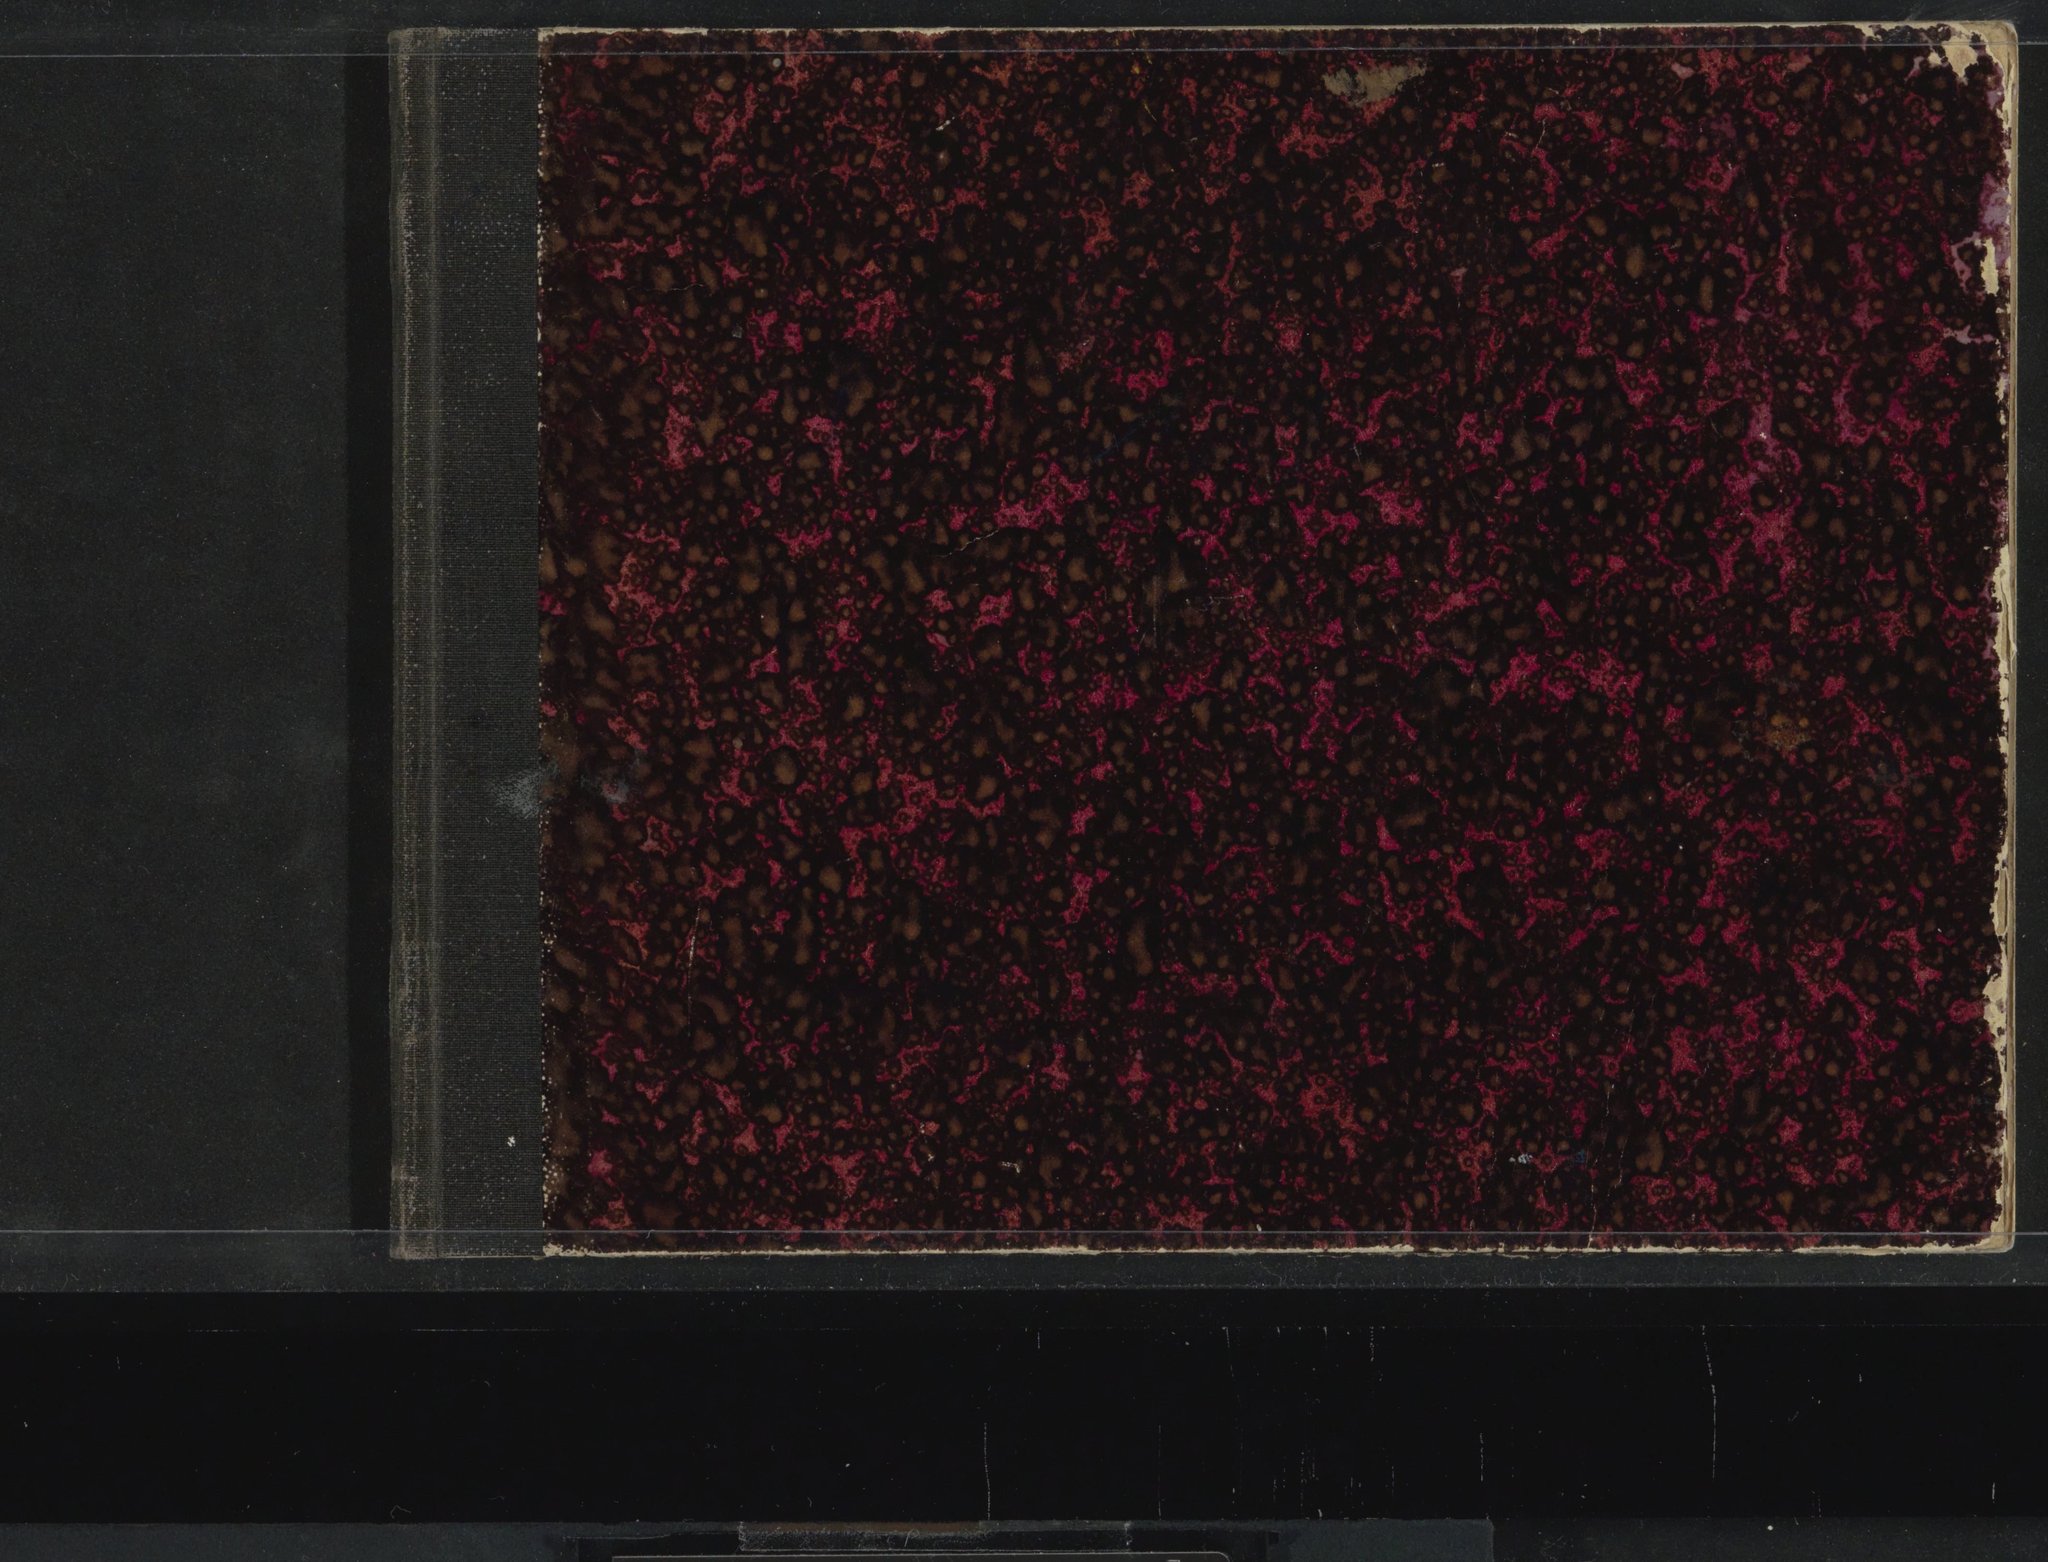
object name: sketchbook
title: Schetsboek XX met 26 bladen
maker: isaac israels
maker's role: draughtsman, painter, print maker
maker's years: 1865-1934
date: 1875-1934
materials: cardboard, chalk, linen, paper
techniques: marbling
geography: amsterdam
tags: adult woman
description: Bladen 5(V), 6(R), 8(V), 9(R), 11(V), 12(R), 16(R) en beide schutbladen zijn blanco en daarom niet beschreven.